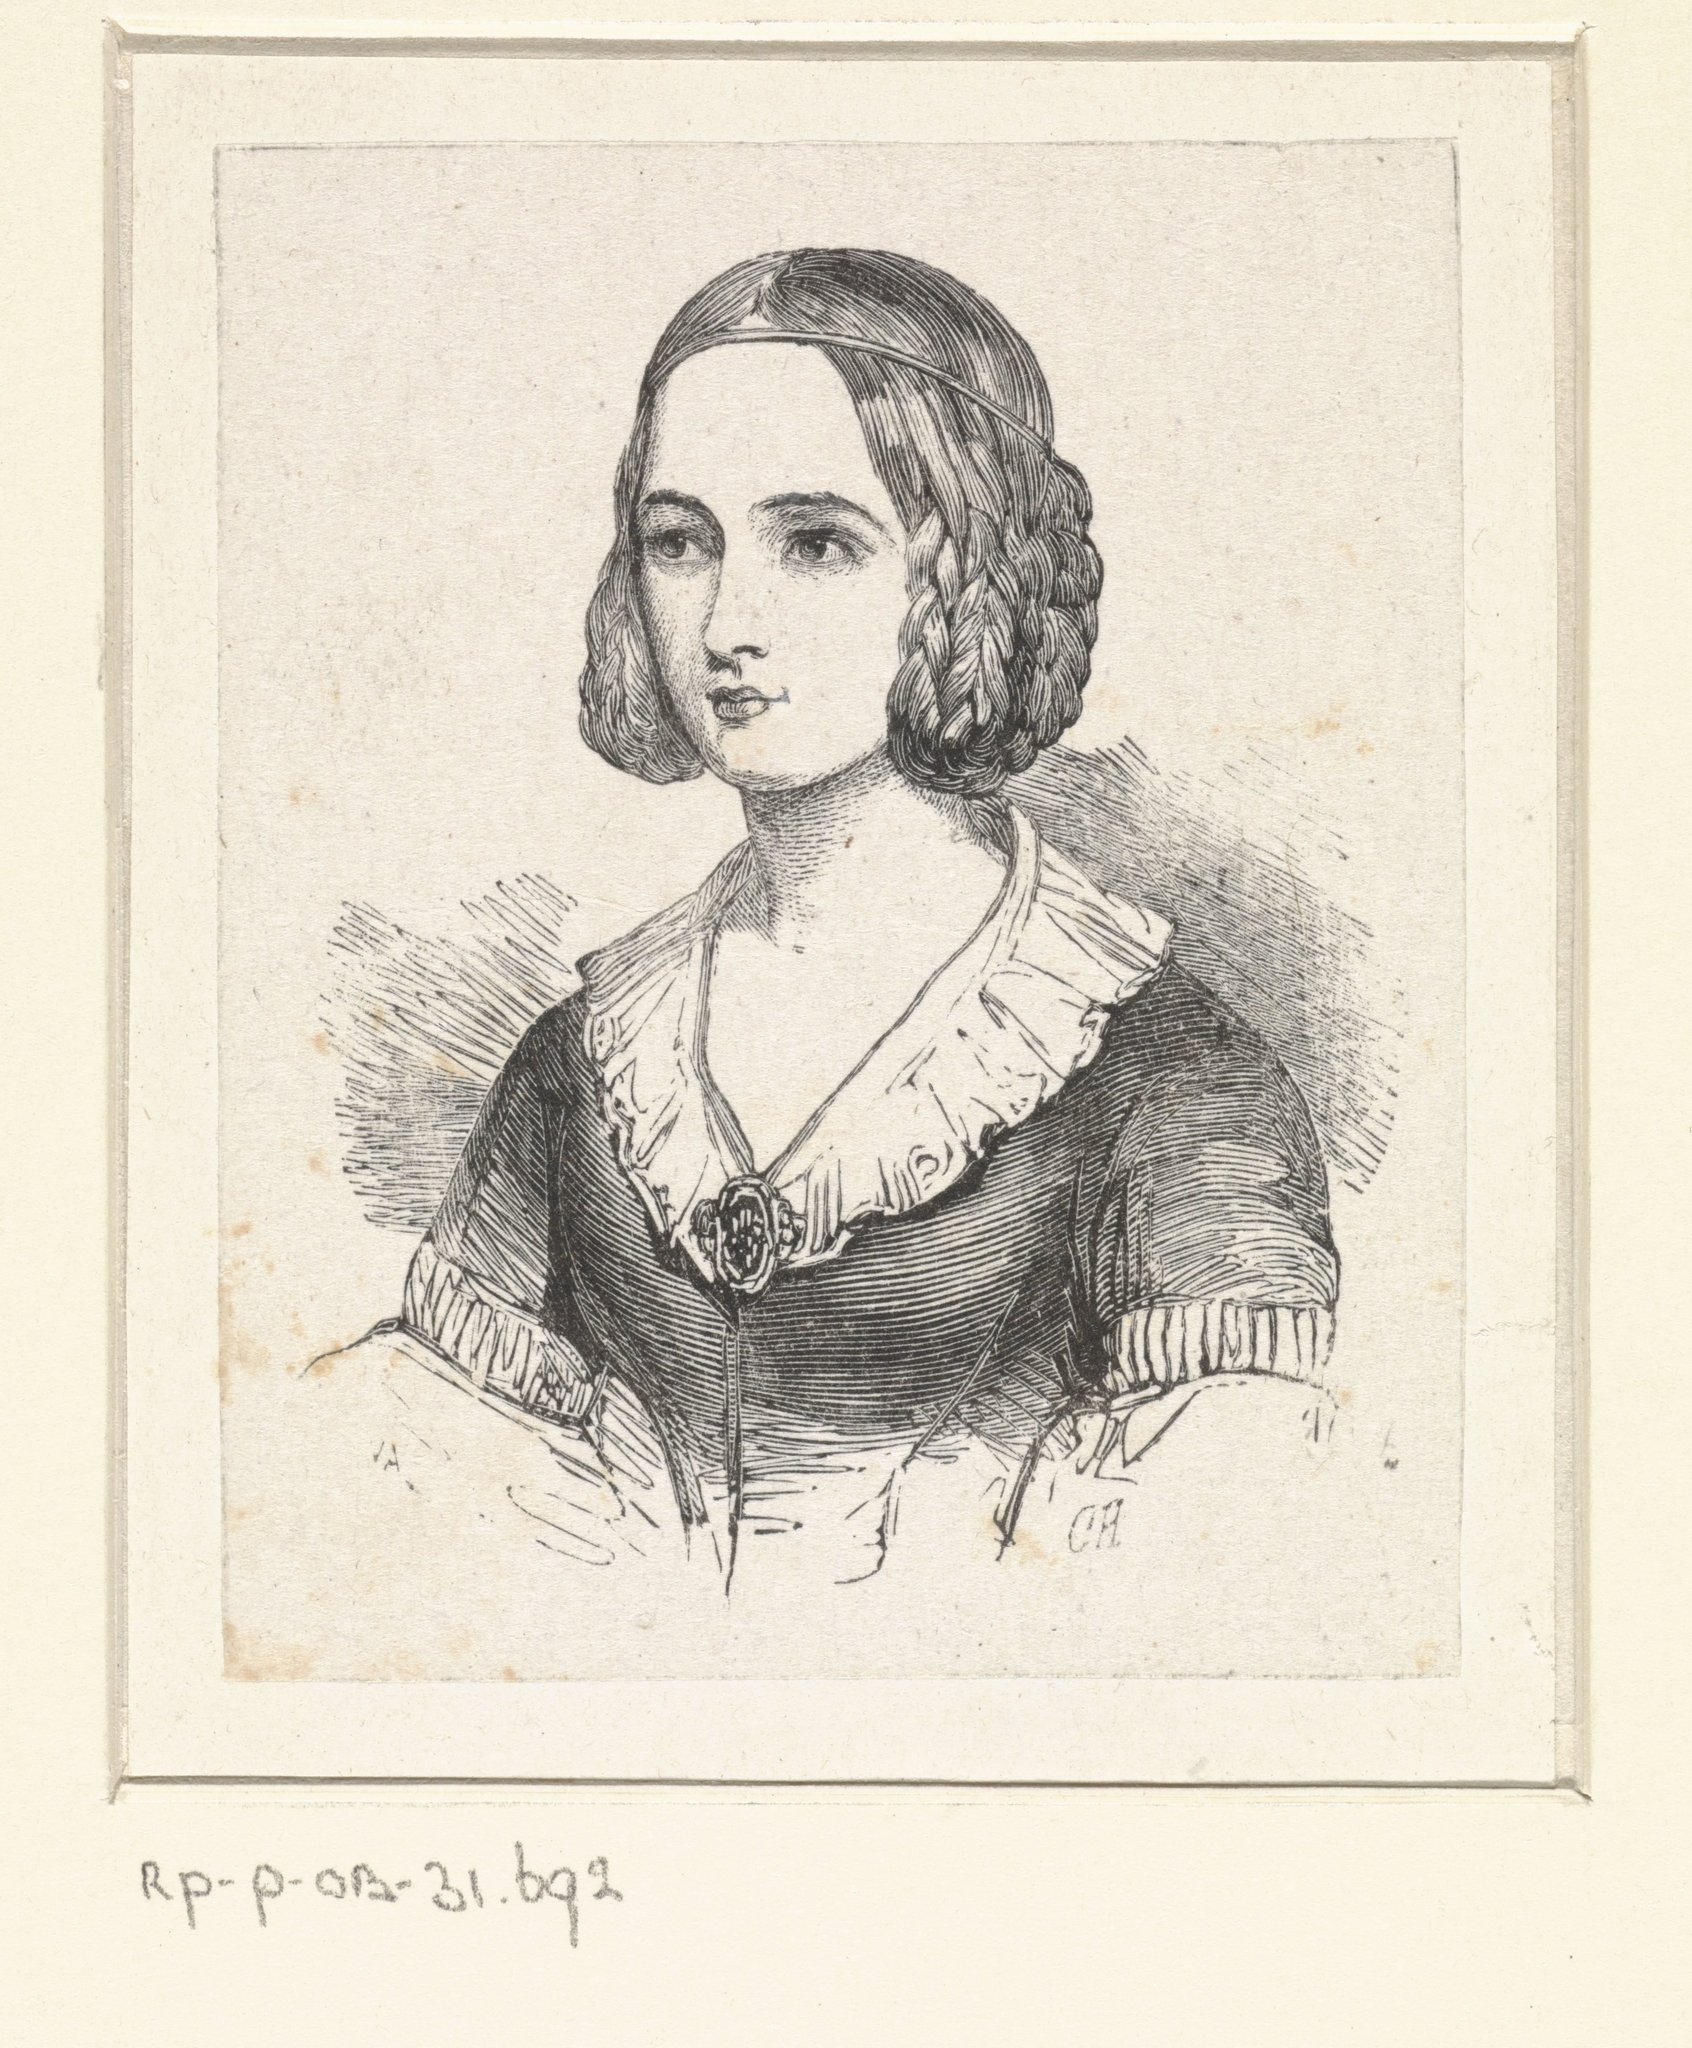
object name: print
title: Portret van Fanny Geefs-Corr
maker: fanny geefs-corr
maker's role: draughtsman, painter, print maker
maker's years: 1807-1883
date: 1840-1842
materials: paper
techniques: engraving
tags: brussels, painter, print maker, draughtsman, fanny geefs-corr, historical persons, portrait, self-portrait of painter, portrait, self-portrait of artist, portrait, self-portrait of draughtsman